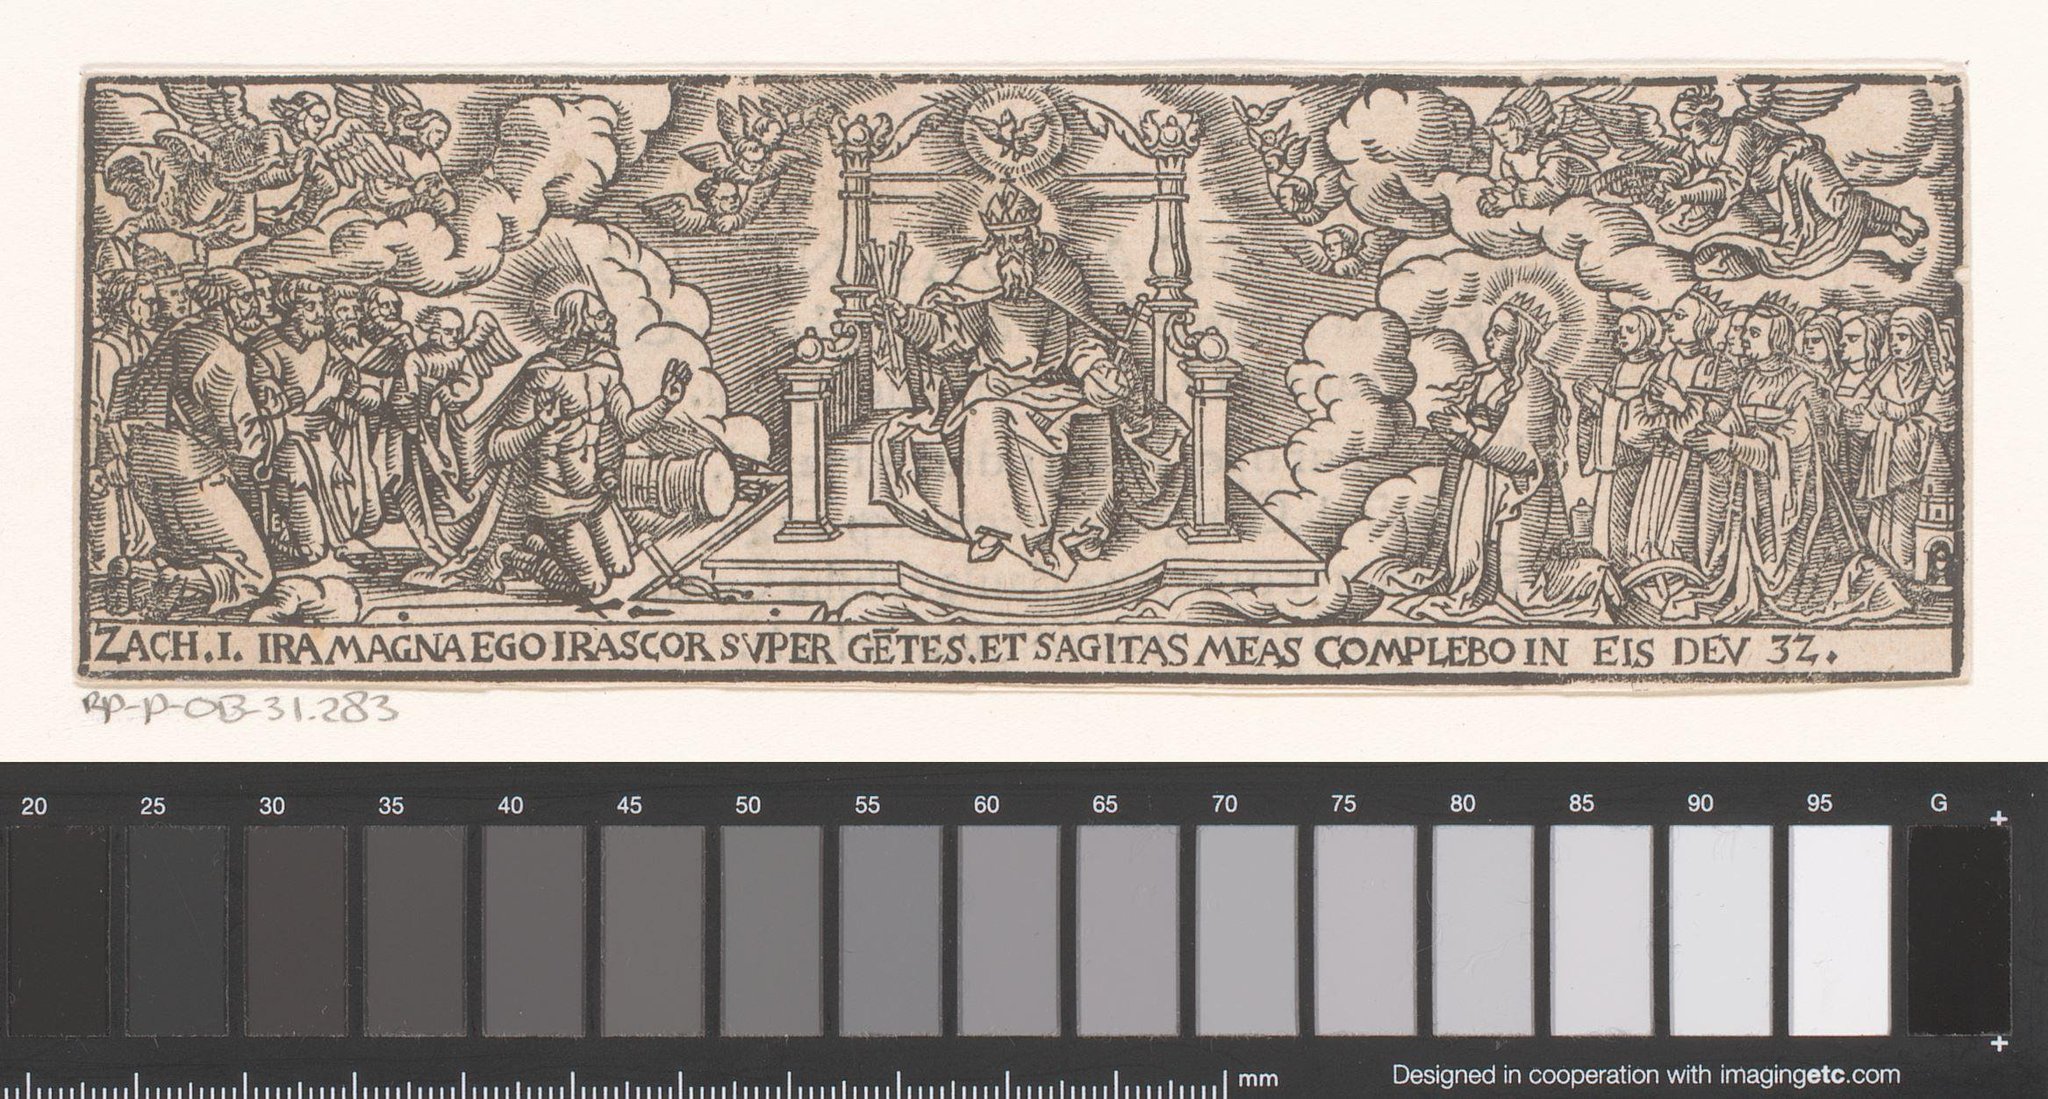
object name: print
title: Christus, de maagd Maria en de heiligen geknield voor de troon van God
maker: anton von woensam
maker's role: print maker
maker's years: 1500-1541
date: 1500-1541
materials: paper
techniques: woodcut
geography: germany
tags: the virgin mary, god the father, saints, christ